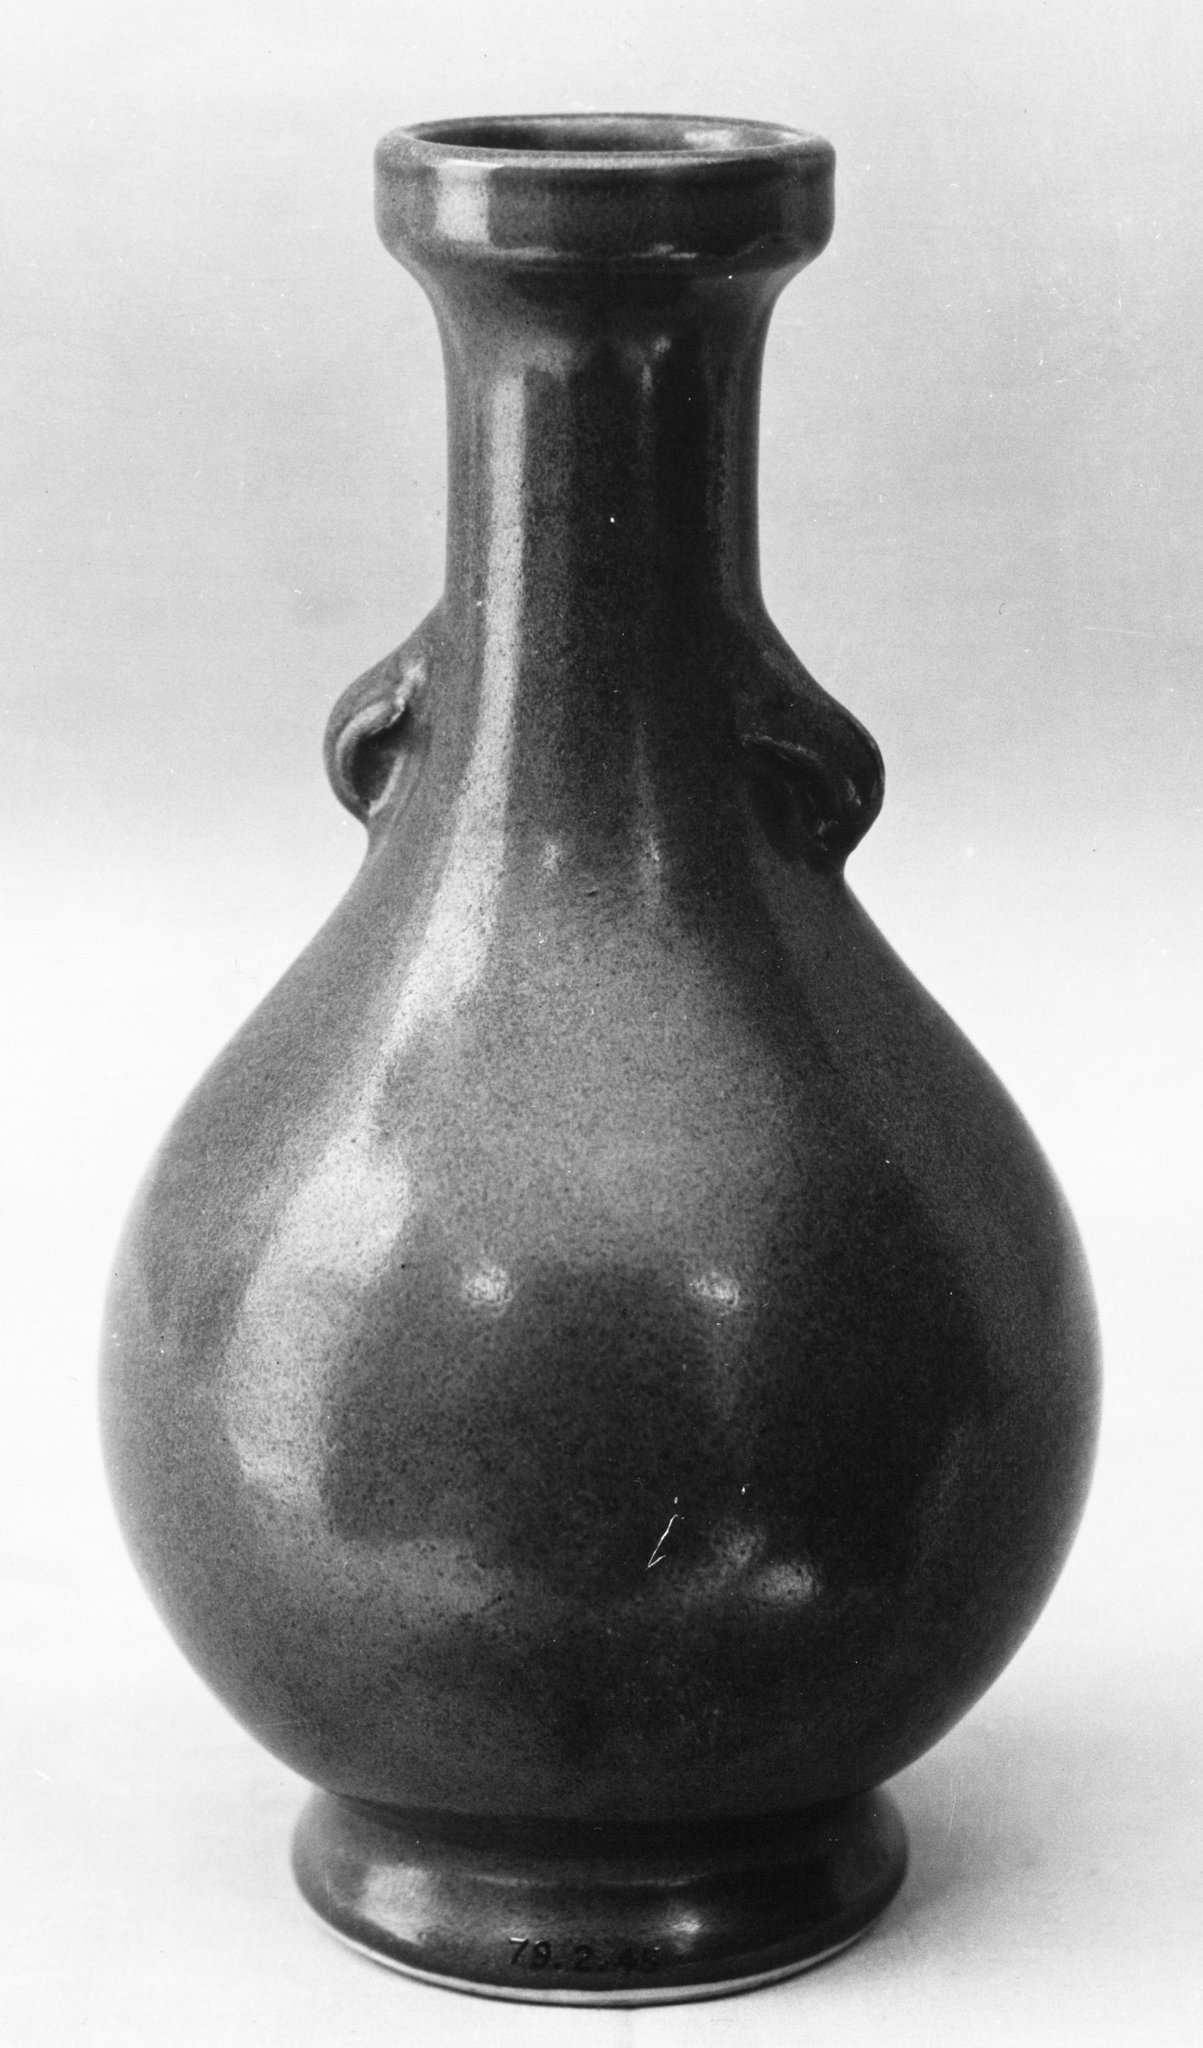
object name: vase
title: Vase with animal-mask handles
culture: chinese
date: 1701-1800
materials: glaze, porcelain